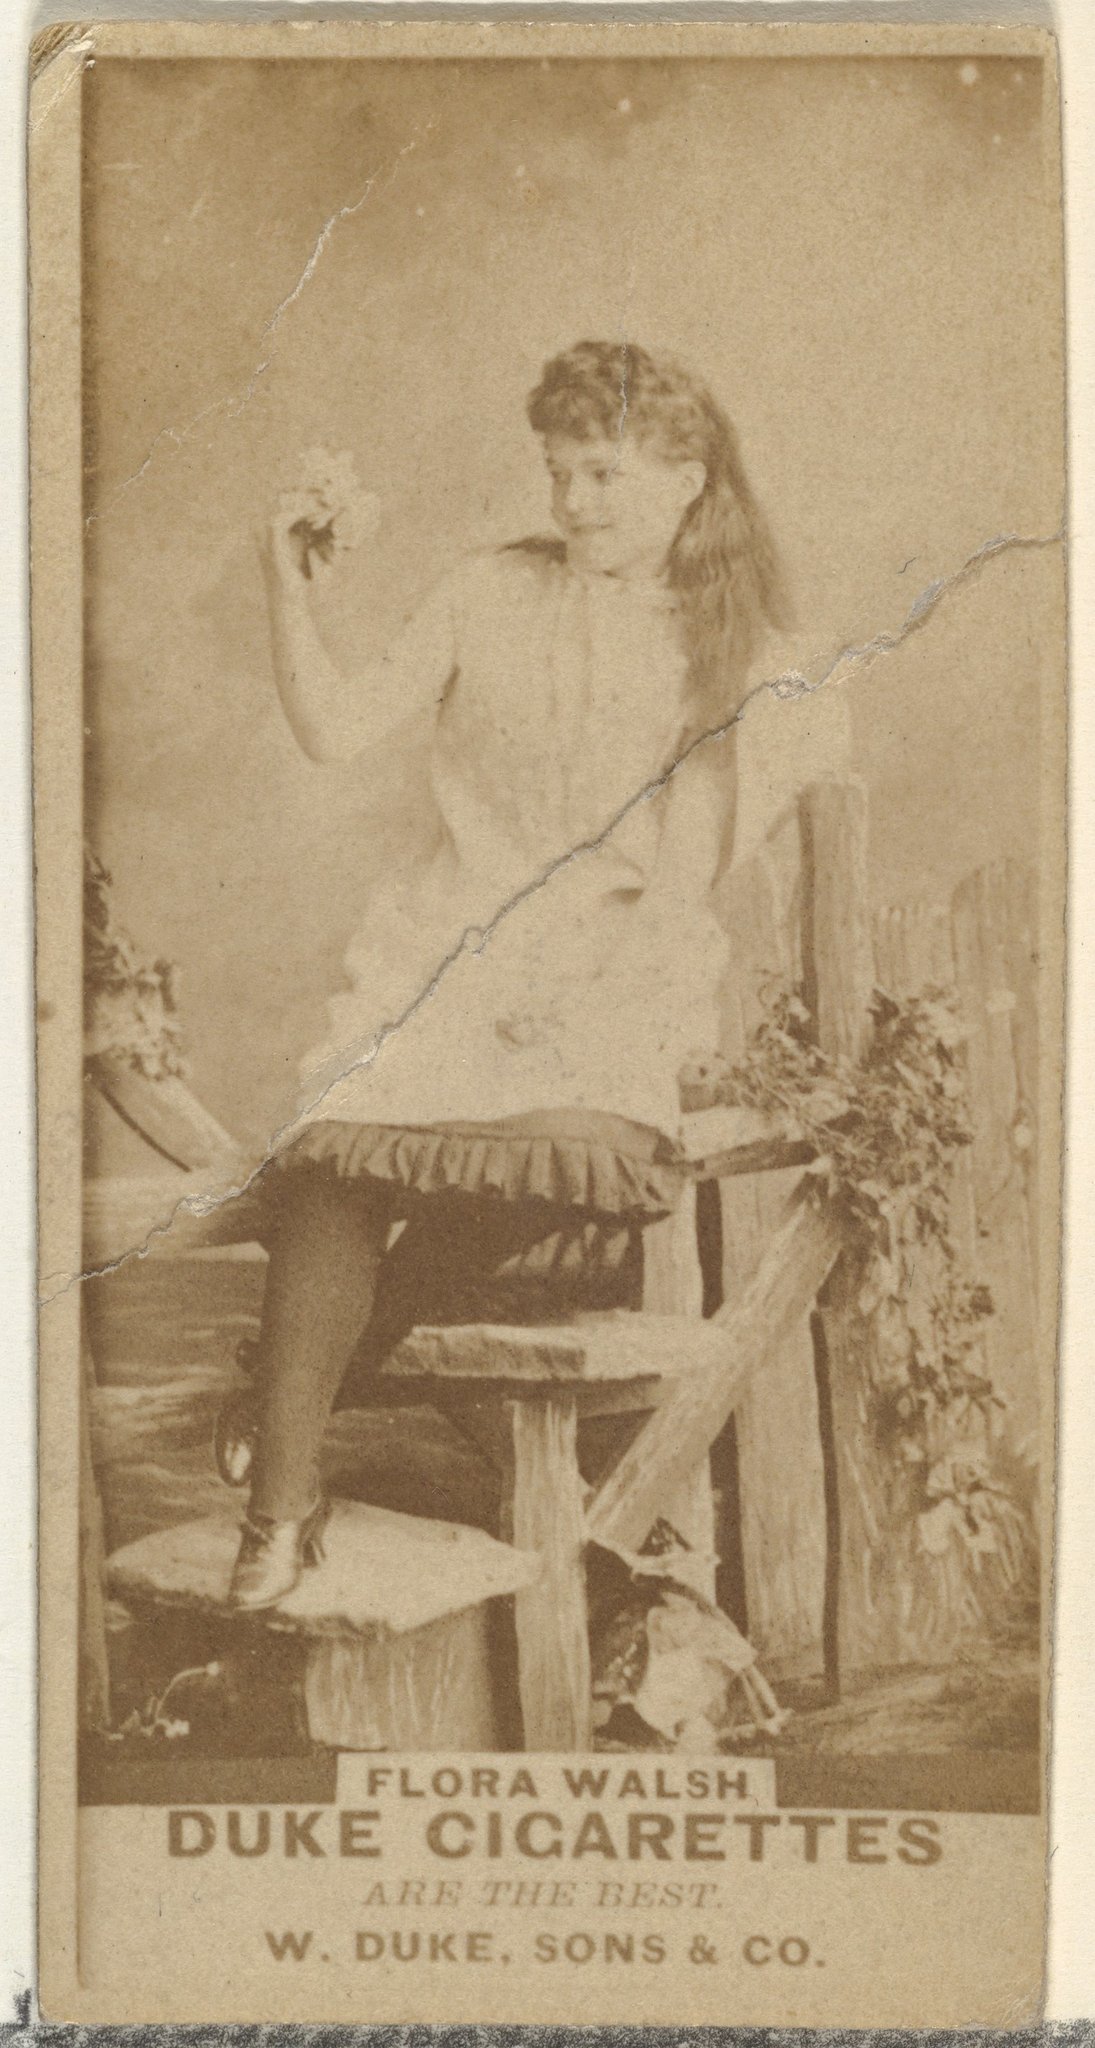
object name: photograph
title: Flora Walsh, from the Actors and Actresses series (N145-7) issued by Duke Sons & Co. to promote Duke Cigarettes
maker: w. duke, sons & co.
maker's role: publisher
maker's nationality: american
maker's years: 1870-1920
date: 1880-1889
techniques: albumen silver print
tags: portraits,women,actresses